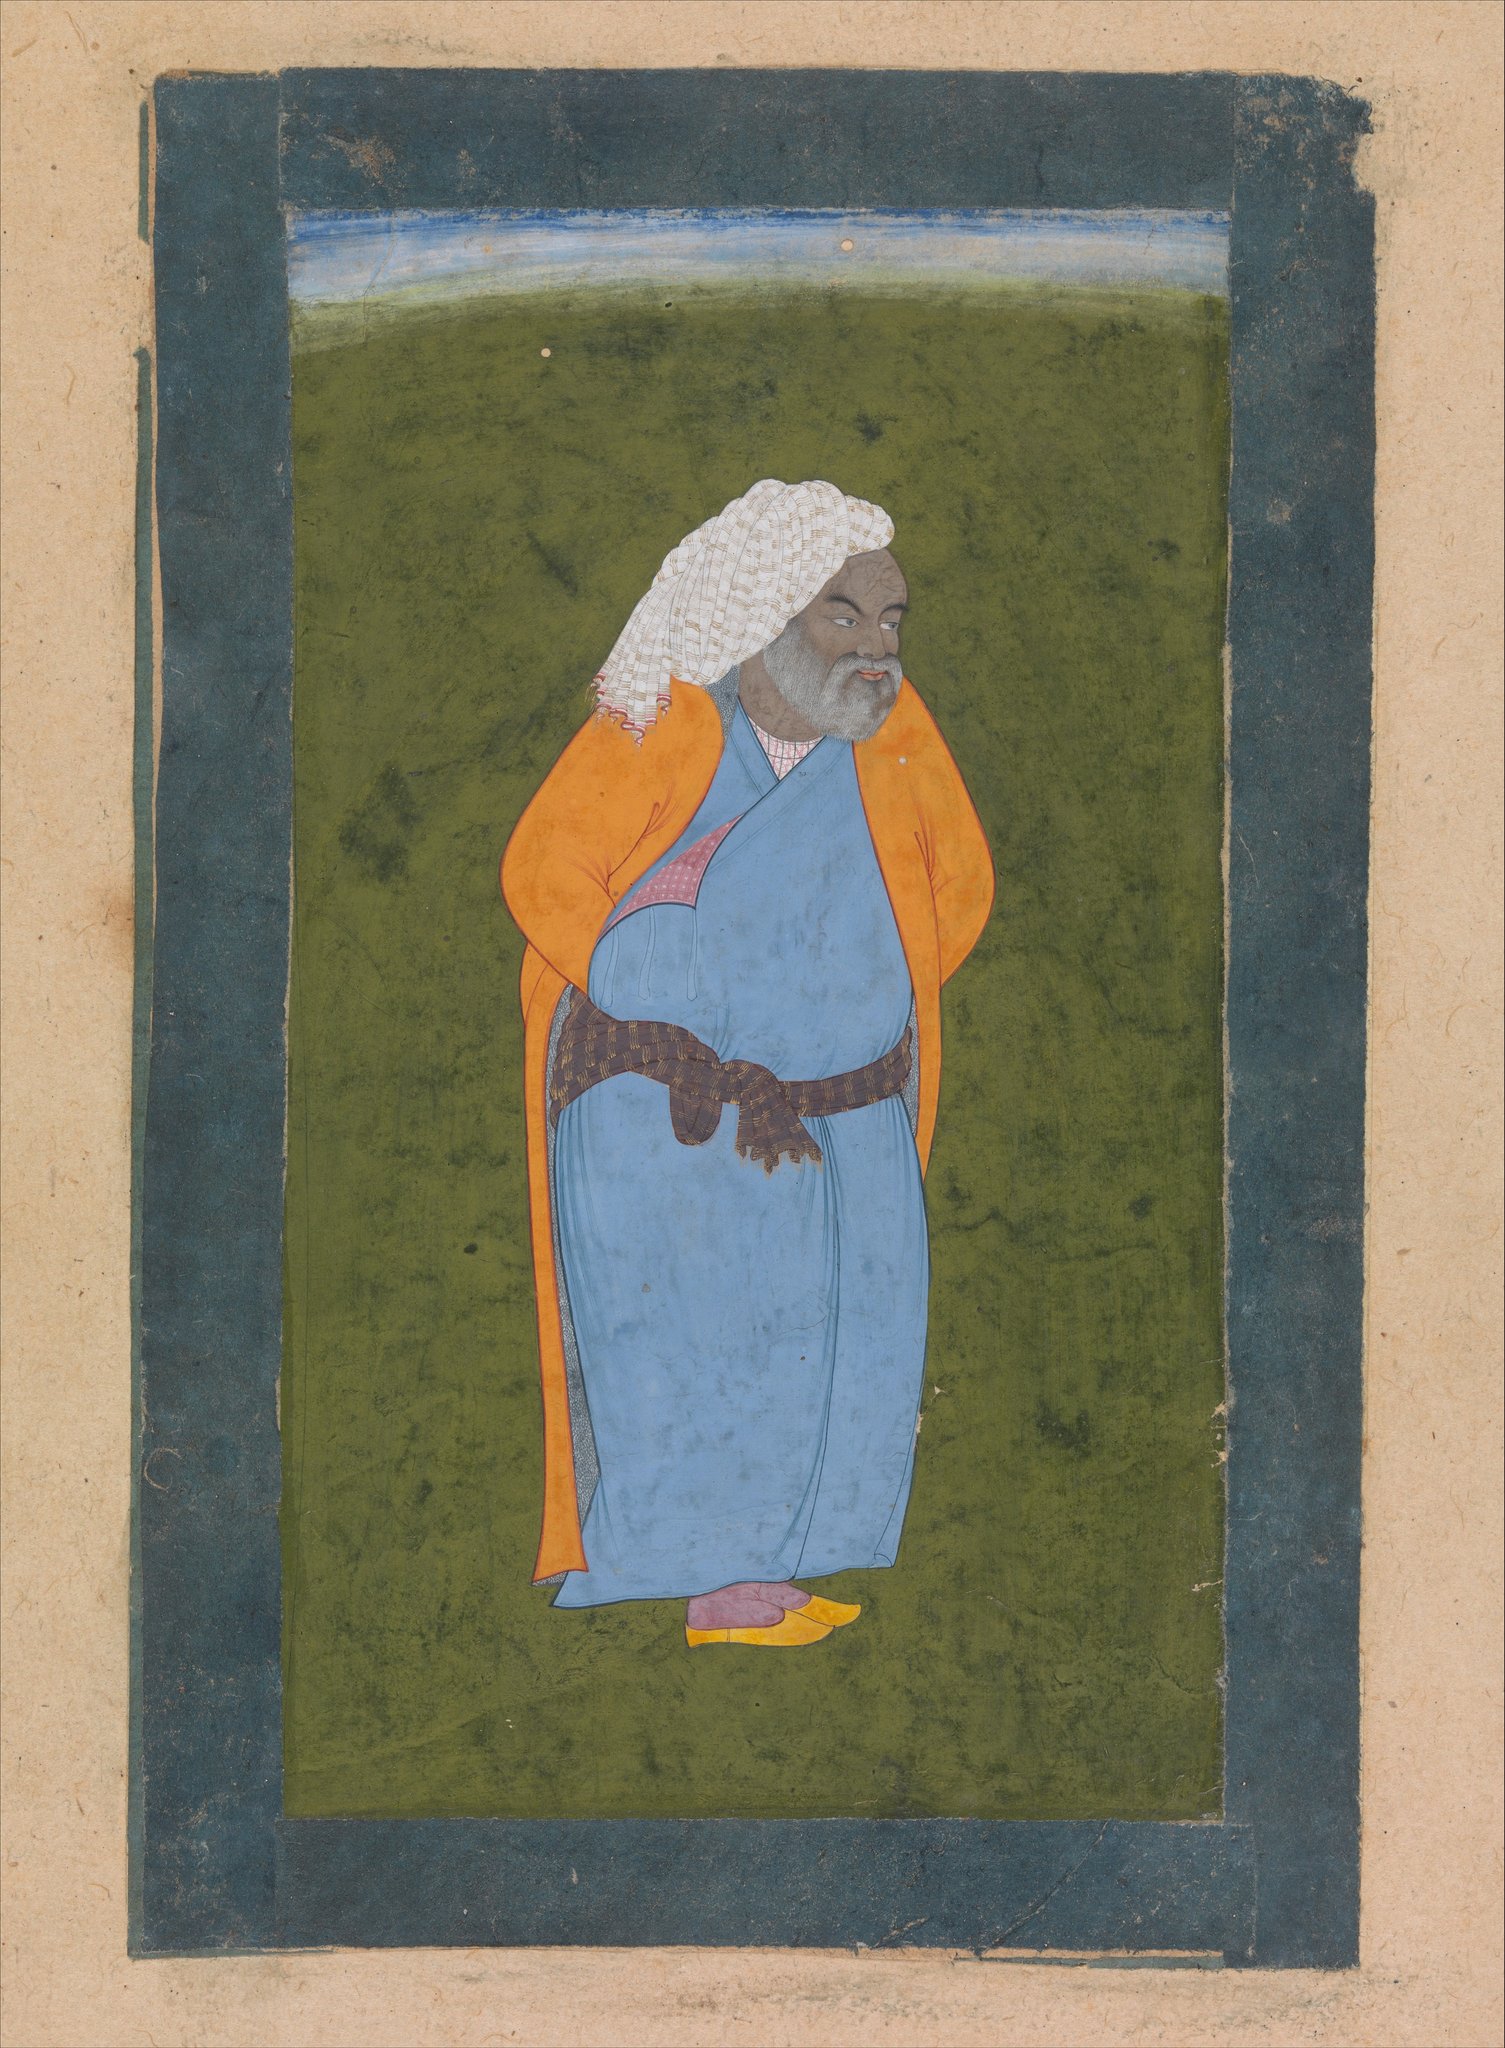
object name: illustrated album leaf or single work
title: Elderly Man of Isfahan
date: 1680-1700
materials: paper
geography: india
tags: men,portraits